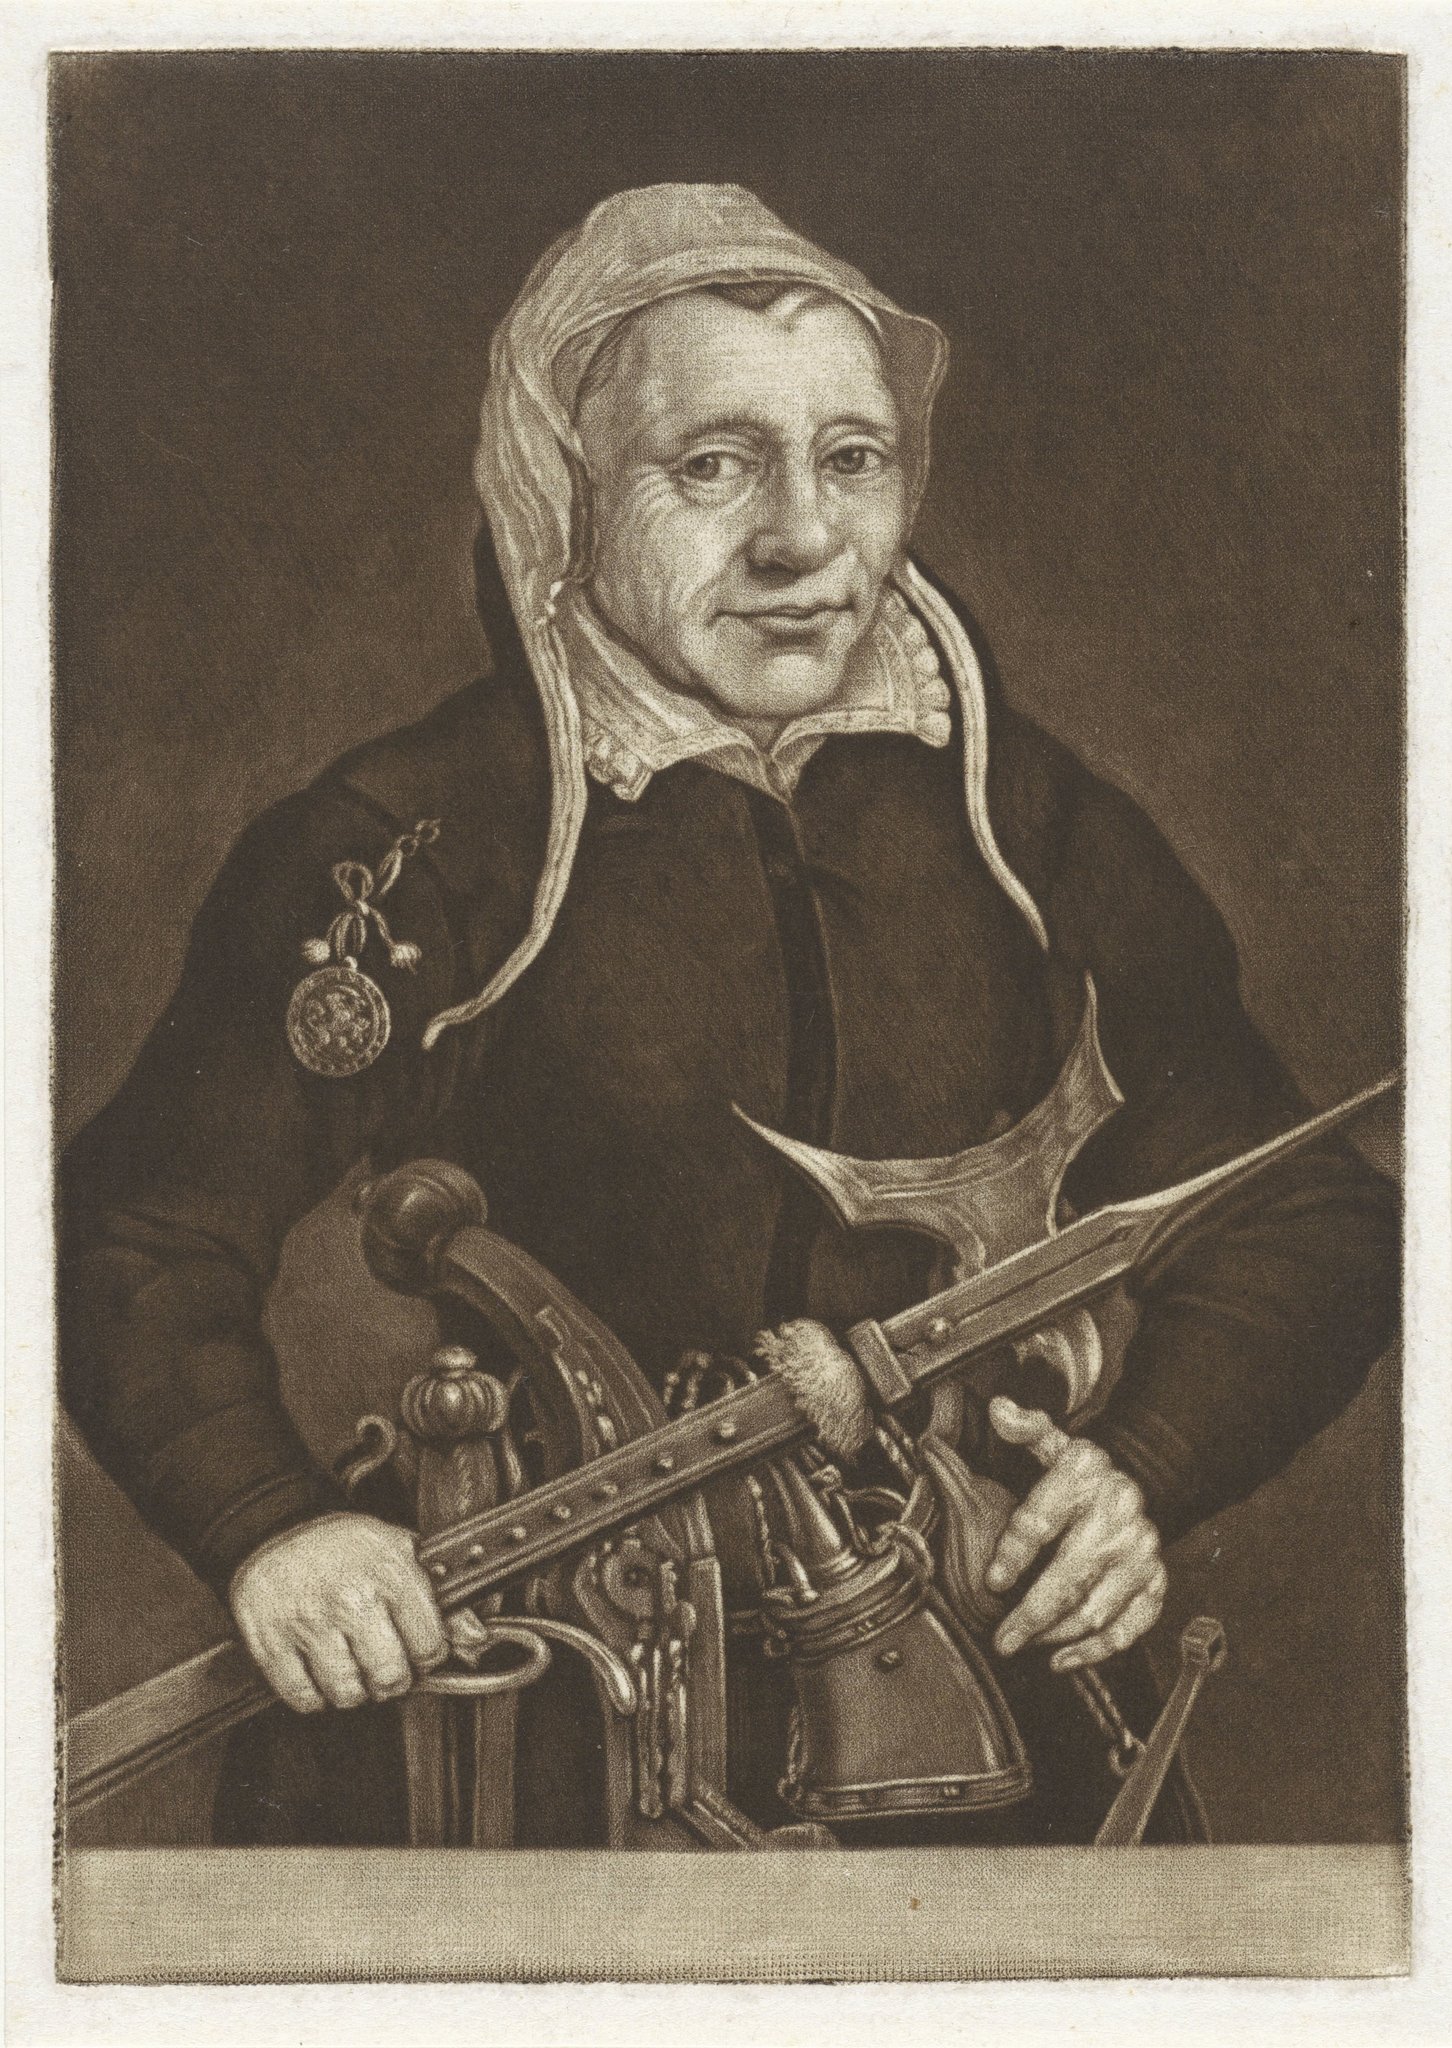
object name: print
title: Portret van Kenau Simonsdochter Hasselaer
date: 1740-1774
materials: paper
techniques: mezzotint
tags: weapons, haarlem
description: Kenau Simonsdochter Hasselaer is bewapend en heeft op haar rechterarm een medaillon met de Hollandse Leeuw.